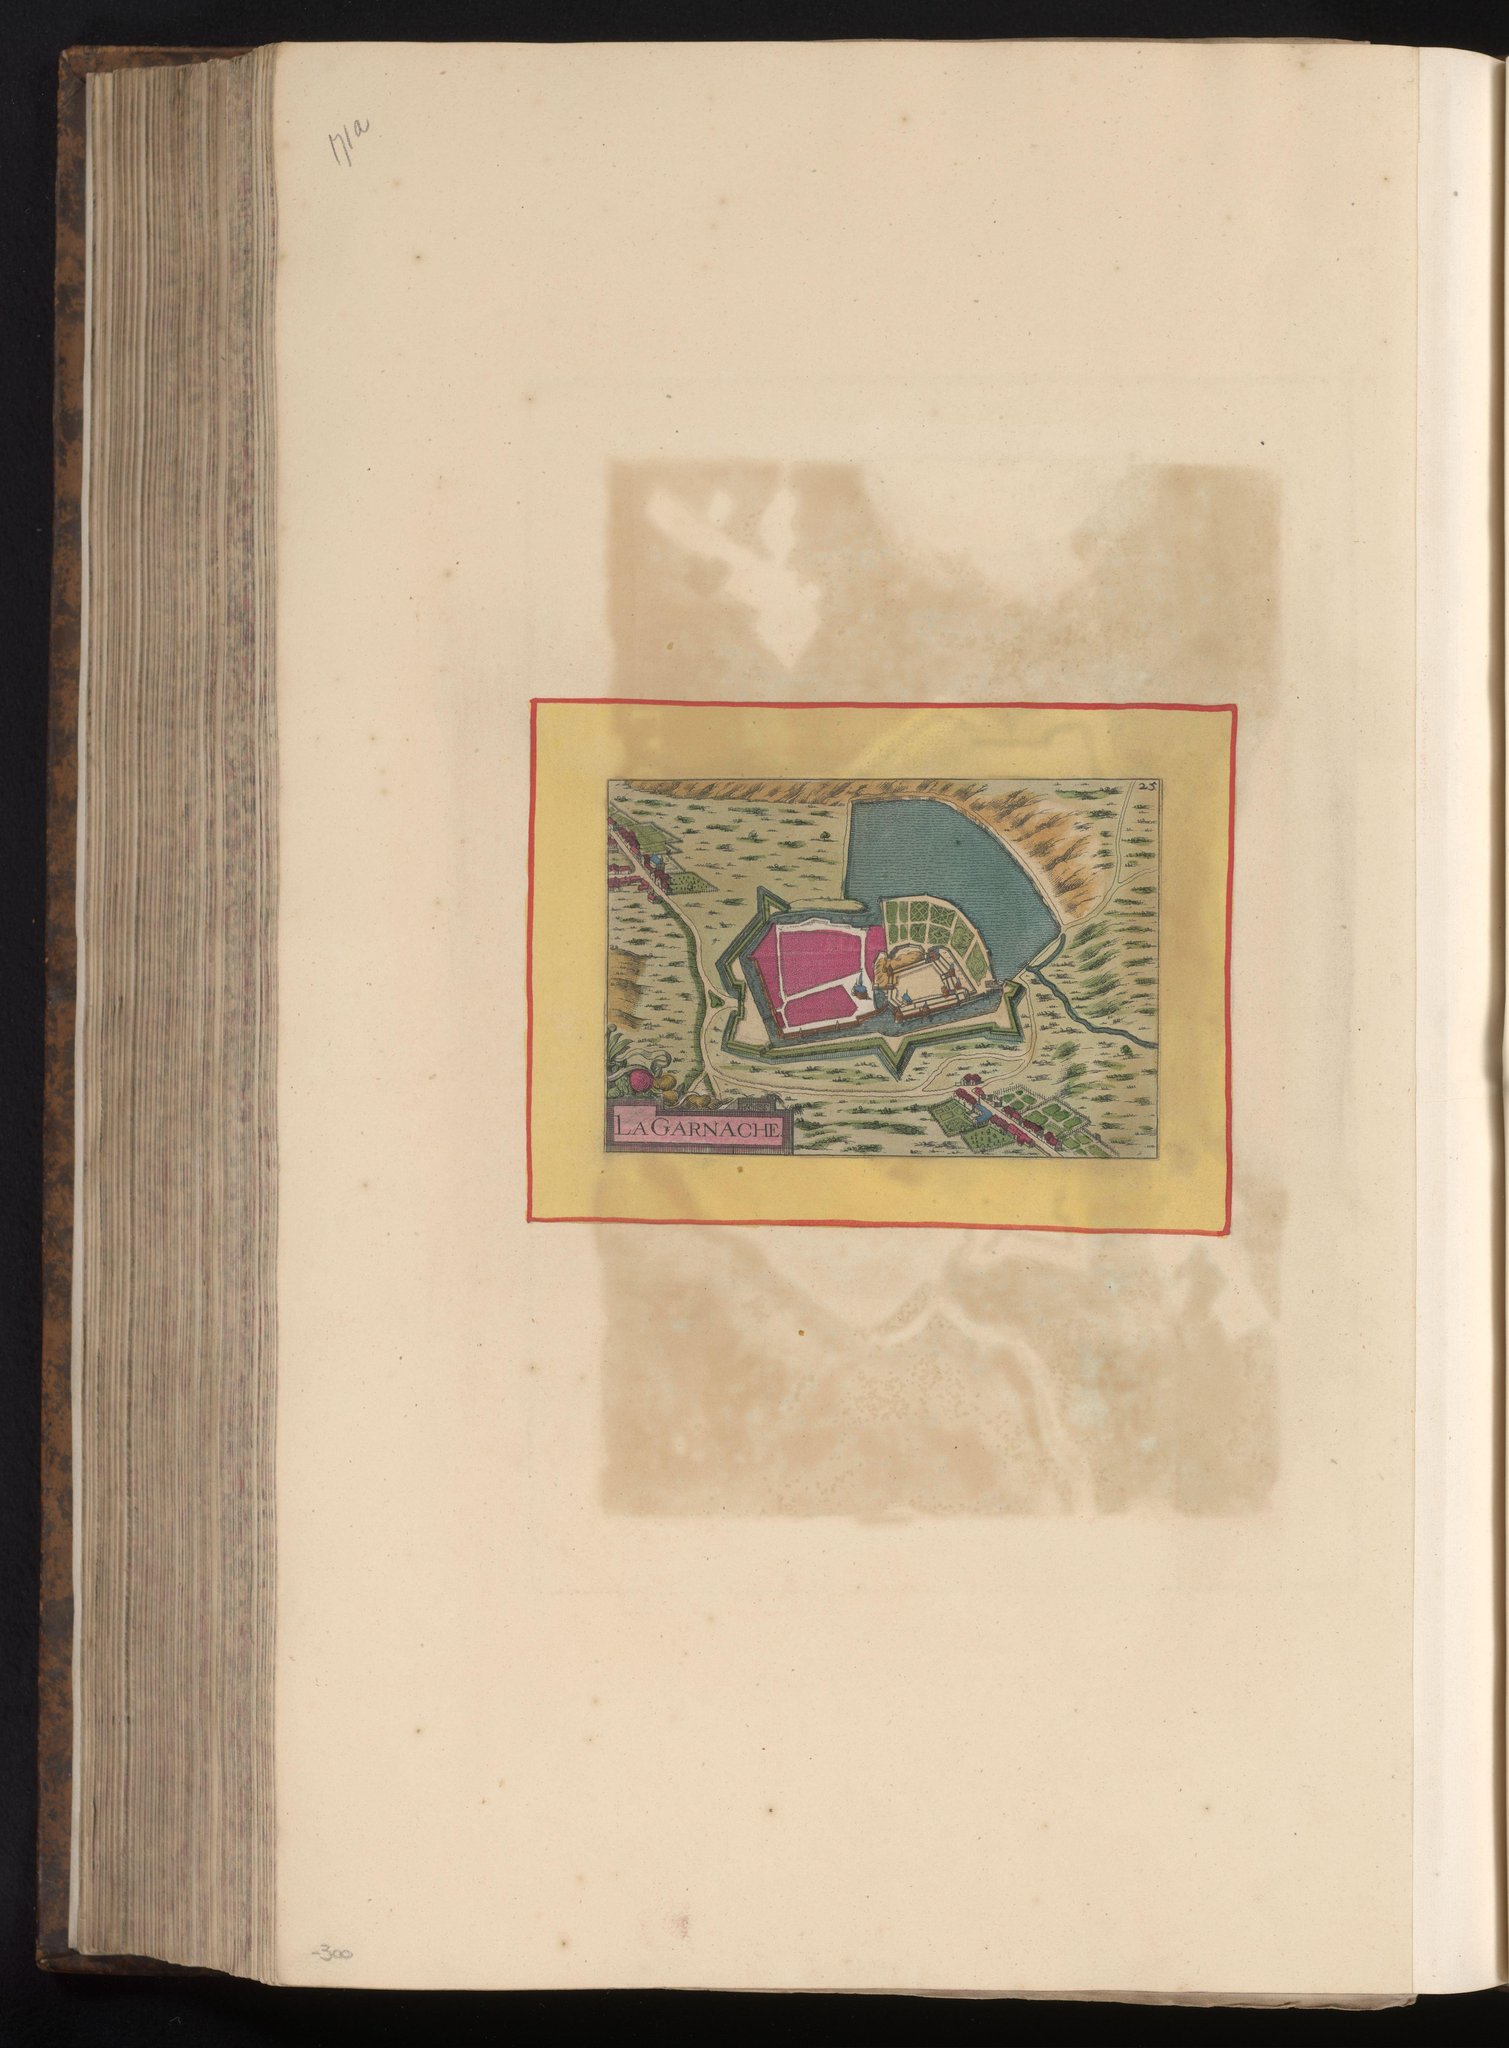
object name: area plan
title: Plattegrond van La Garnache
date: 1638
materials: paper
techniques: engraving, etching, hand coloring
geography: paris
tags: maps of cities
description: Prent uit: Tassin, Christophe. Les plans et profils de toutes les principales villes et lieux considérables de France (...). Parijs: Michel van Lochom, 1638, prent nummer 25 in het deel 'Poictou'.